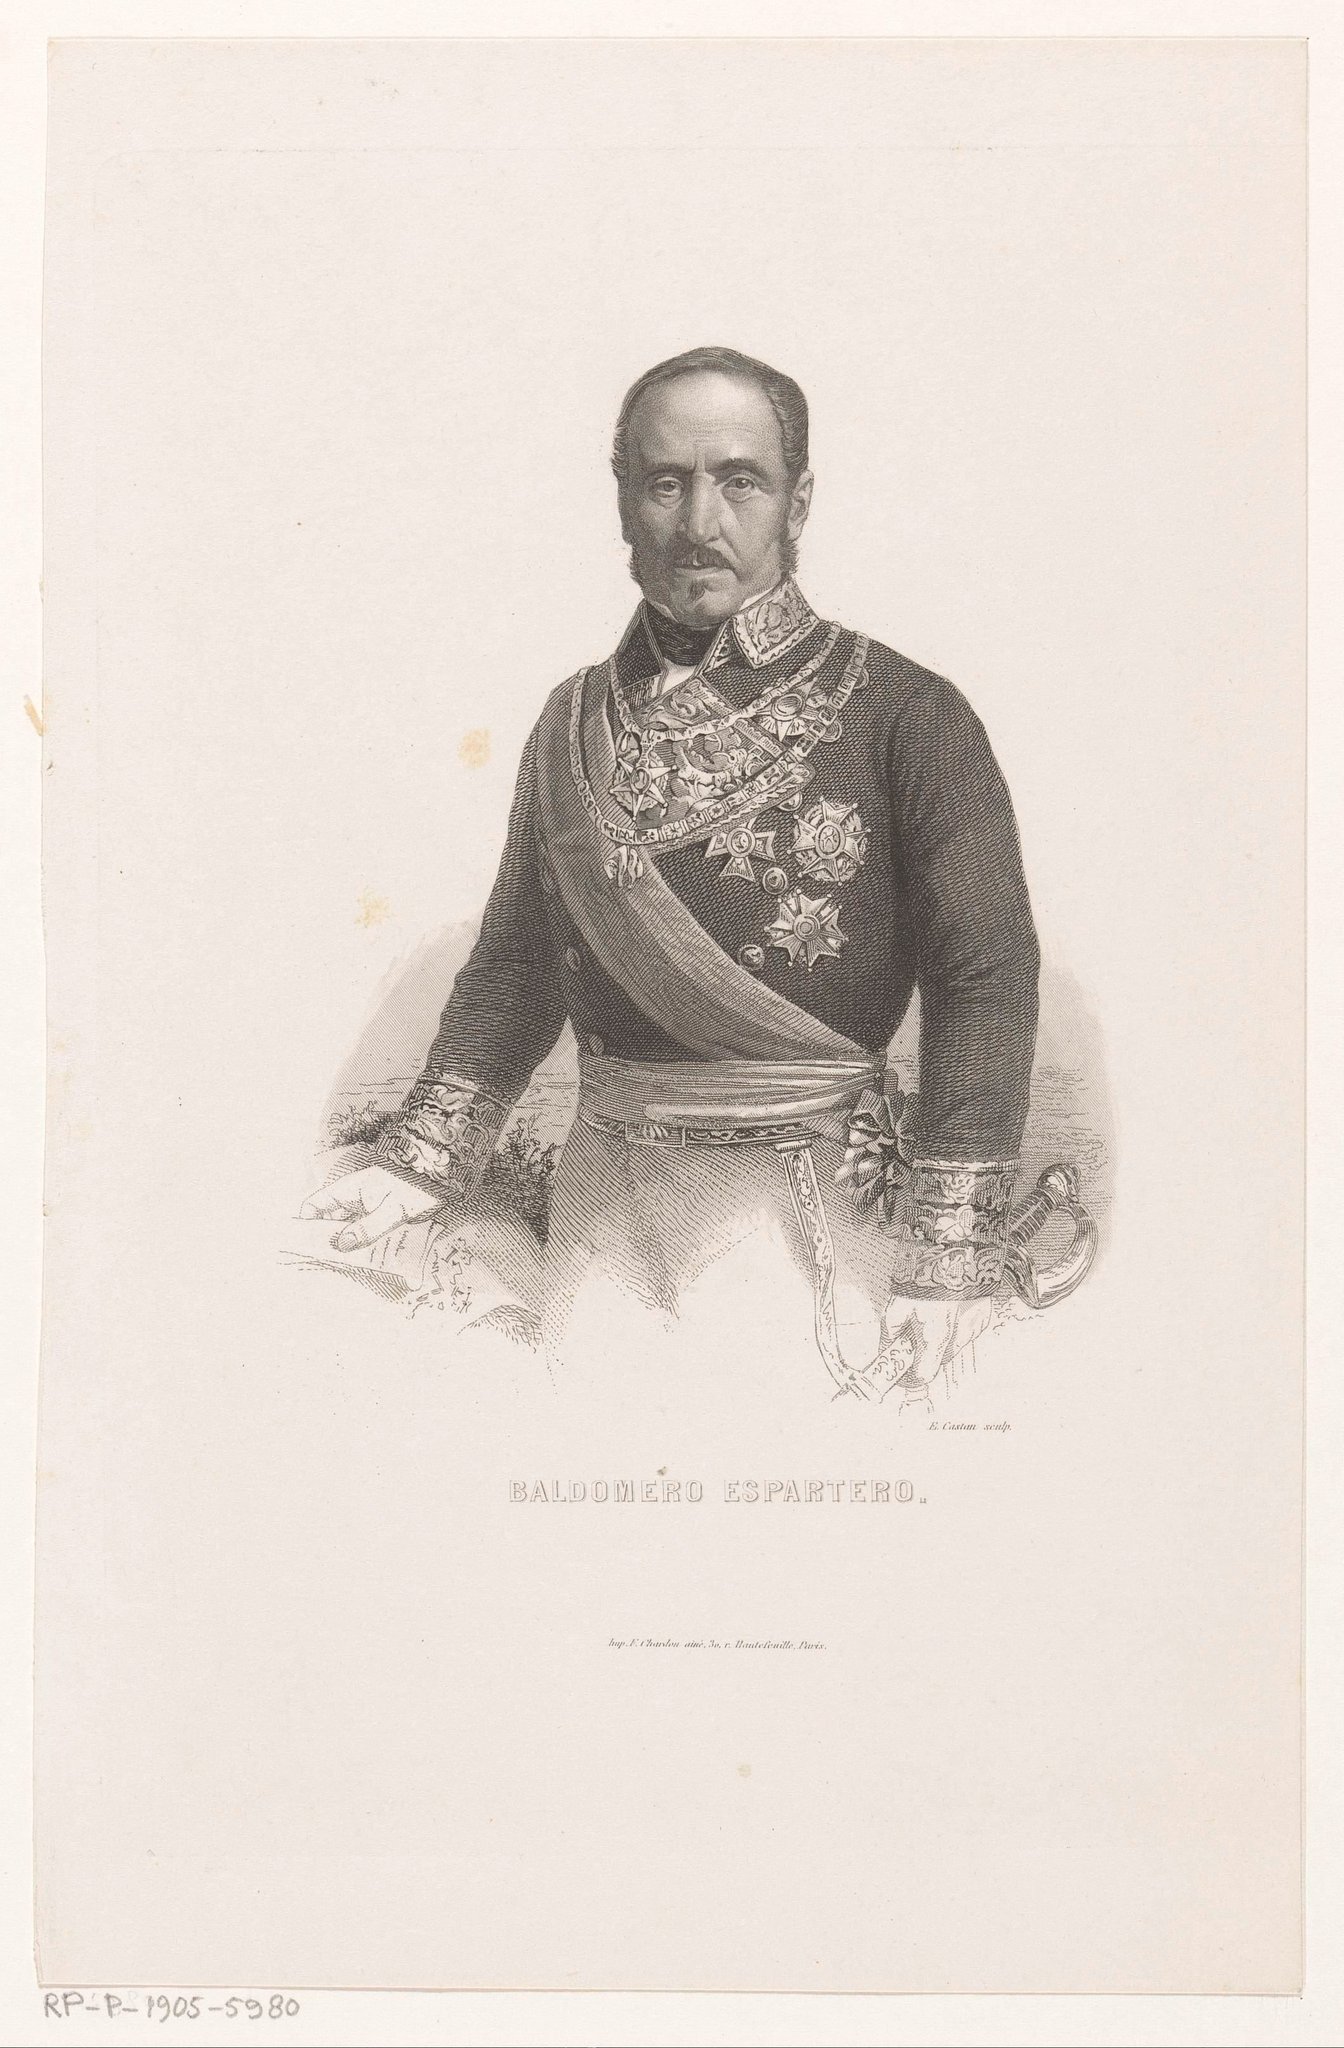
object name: print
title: Portret van Baldomero Espartero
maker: pierre jean edmond castan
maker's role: print maker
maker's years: 1817-1892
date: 1827-1892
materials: paper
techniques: engraving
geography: paris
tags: commander-in-chief, general, marshal, historical persons, politician, e.g. party leader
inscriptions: collector's mark: Lugt 2228